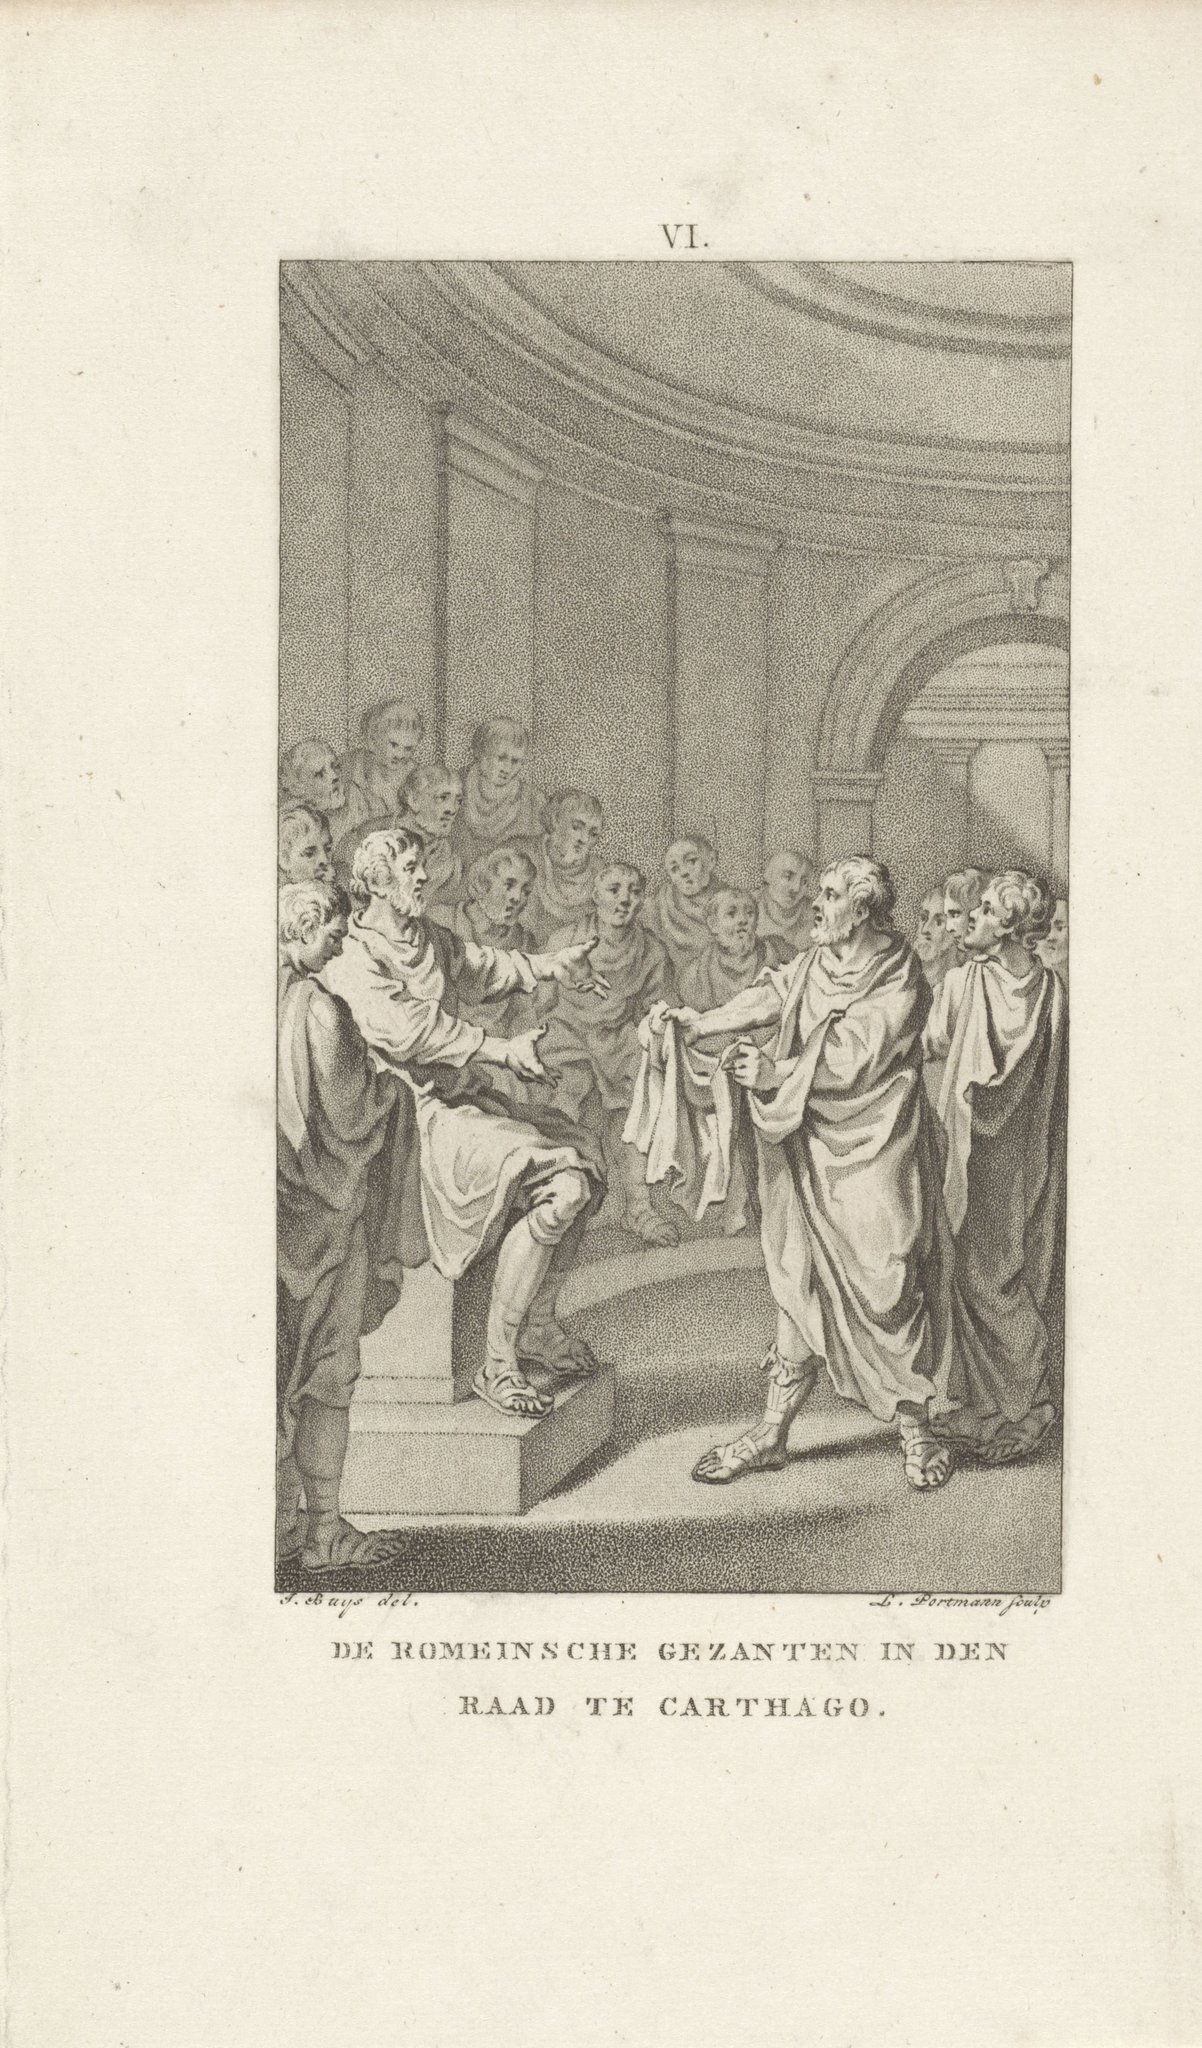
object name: print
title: Quintus Fabius Maximus voor de raad in Carthago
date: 1795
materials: paper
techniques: stippled etching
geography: amsterdam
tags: quintus fabius maximus, surnamed cunctator, gives the council of carthage the choice between war and peace; he is seen gathering the folds of his toga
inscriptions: collector's mark: Lugt 2228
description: De Romeinse generaal Quintus Fabius Maximus Cunctator (de Twijfelaar) laat de raad in Carthago kiezen tussen oorlog of vrede. Hij toont de vouwen in zijn toga.